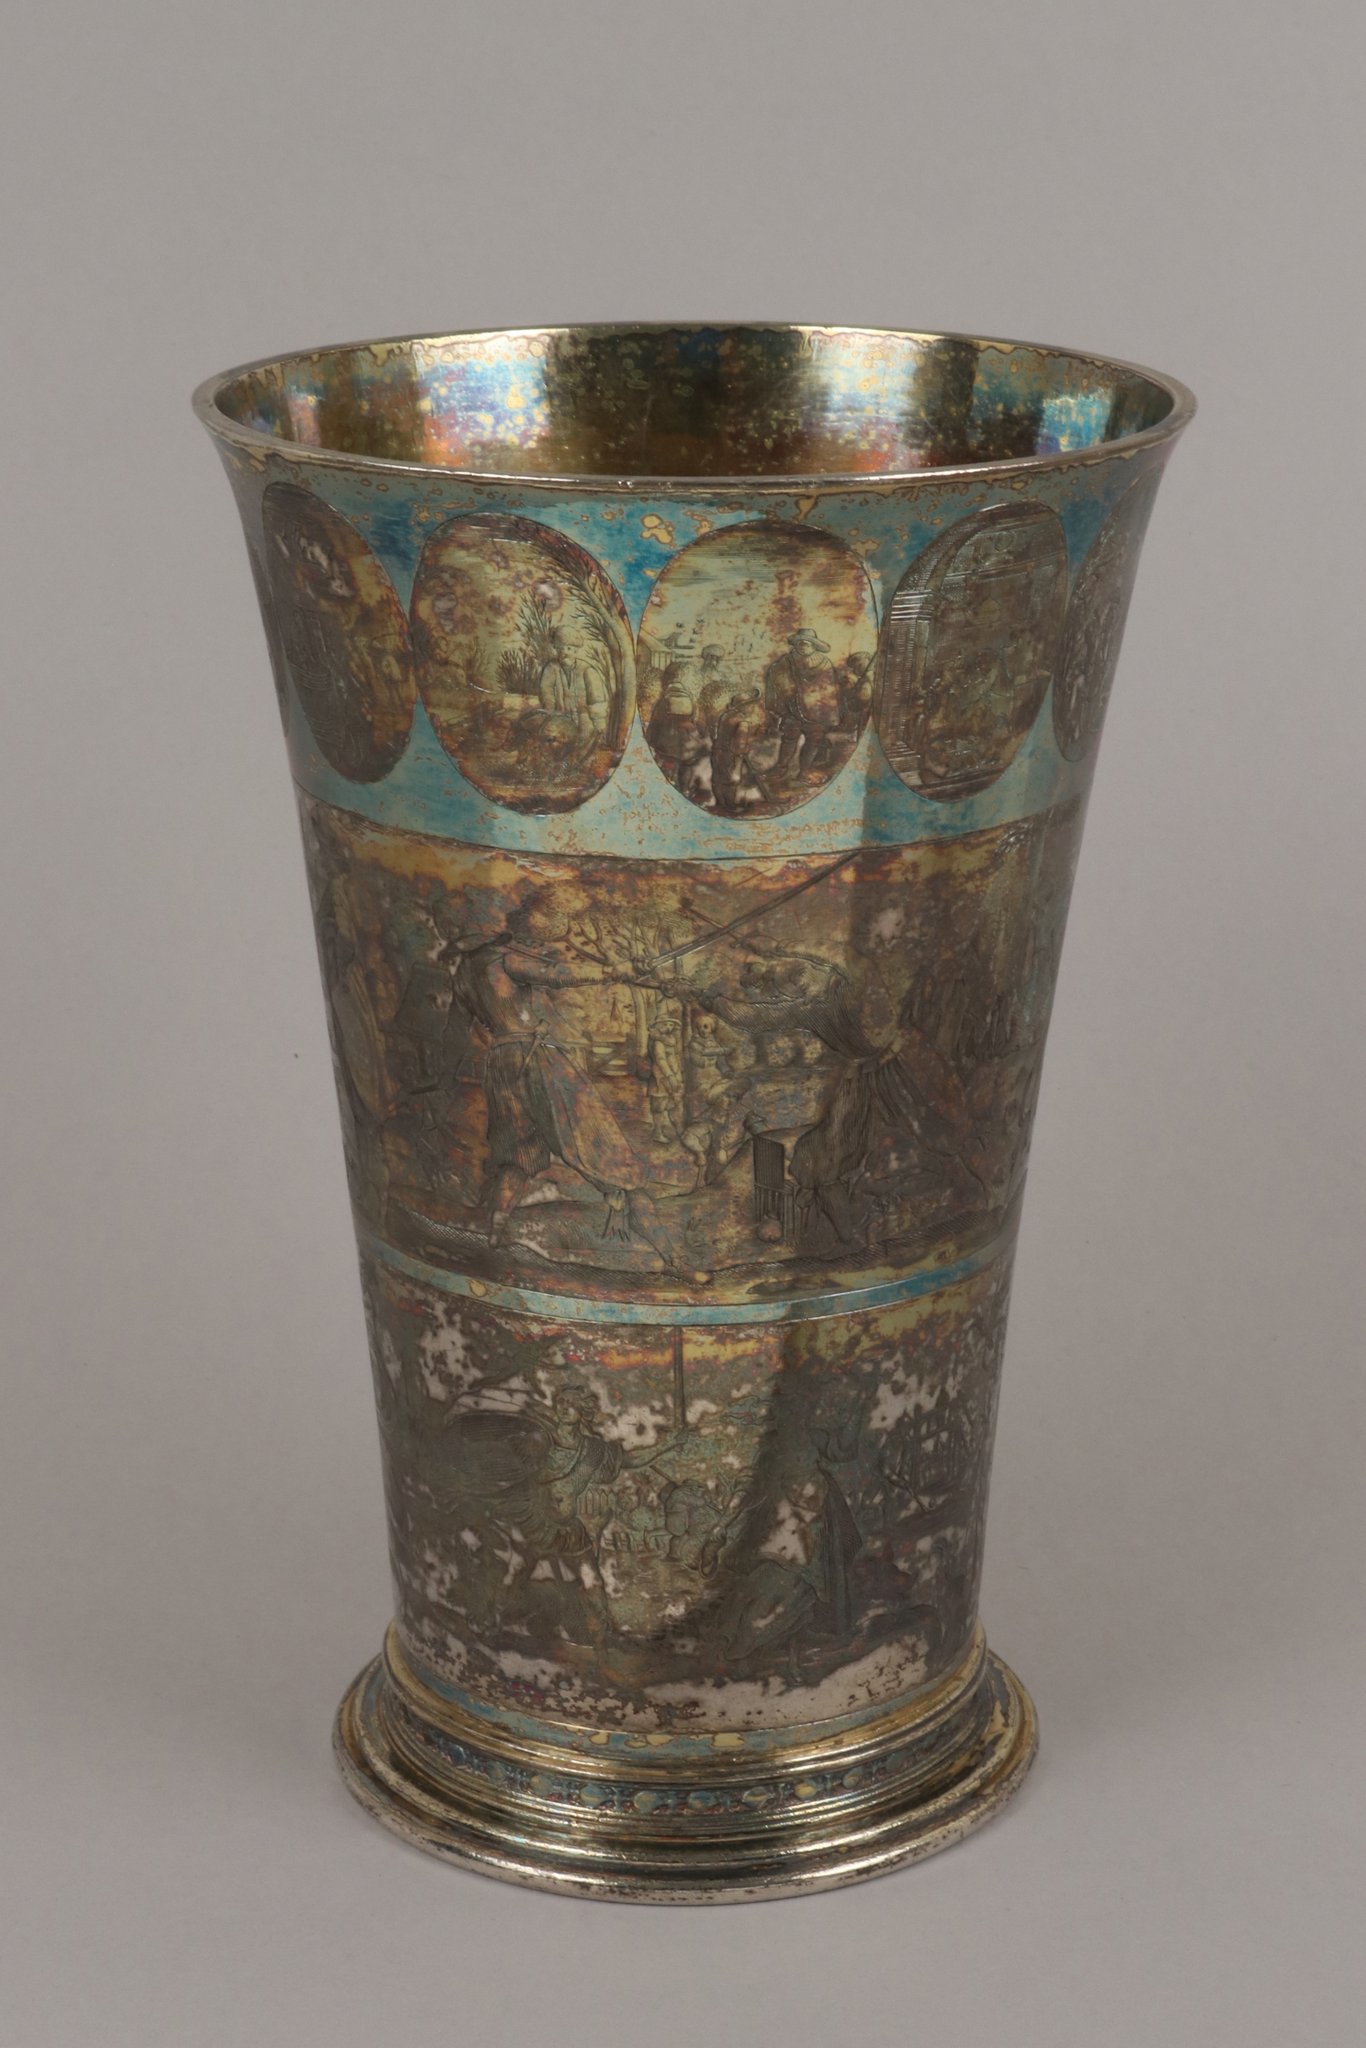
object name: beaker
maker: hans bas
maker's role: engraver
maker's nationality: flemish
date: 1632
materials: gilt, silver